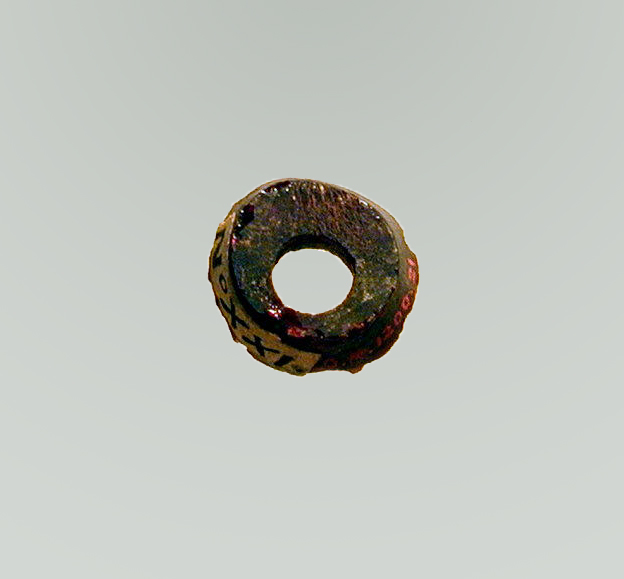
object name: fibula, fragment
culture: etruscan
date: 700-501 BCE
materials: amber